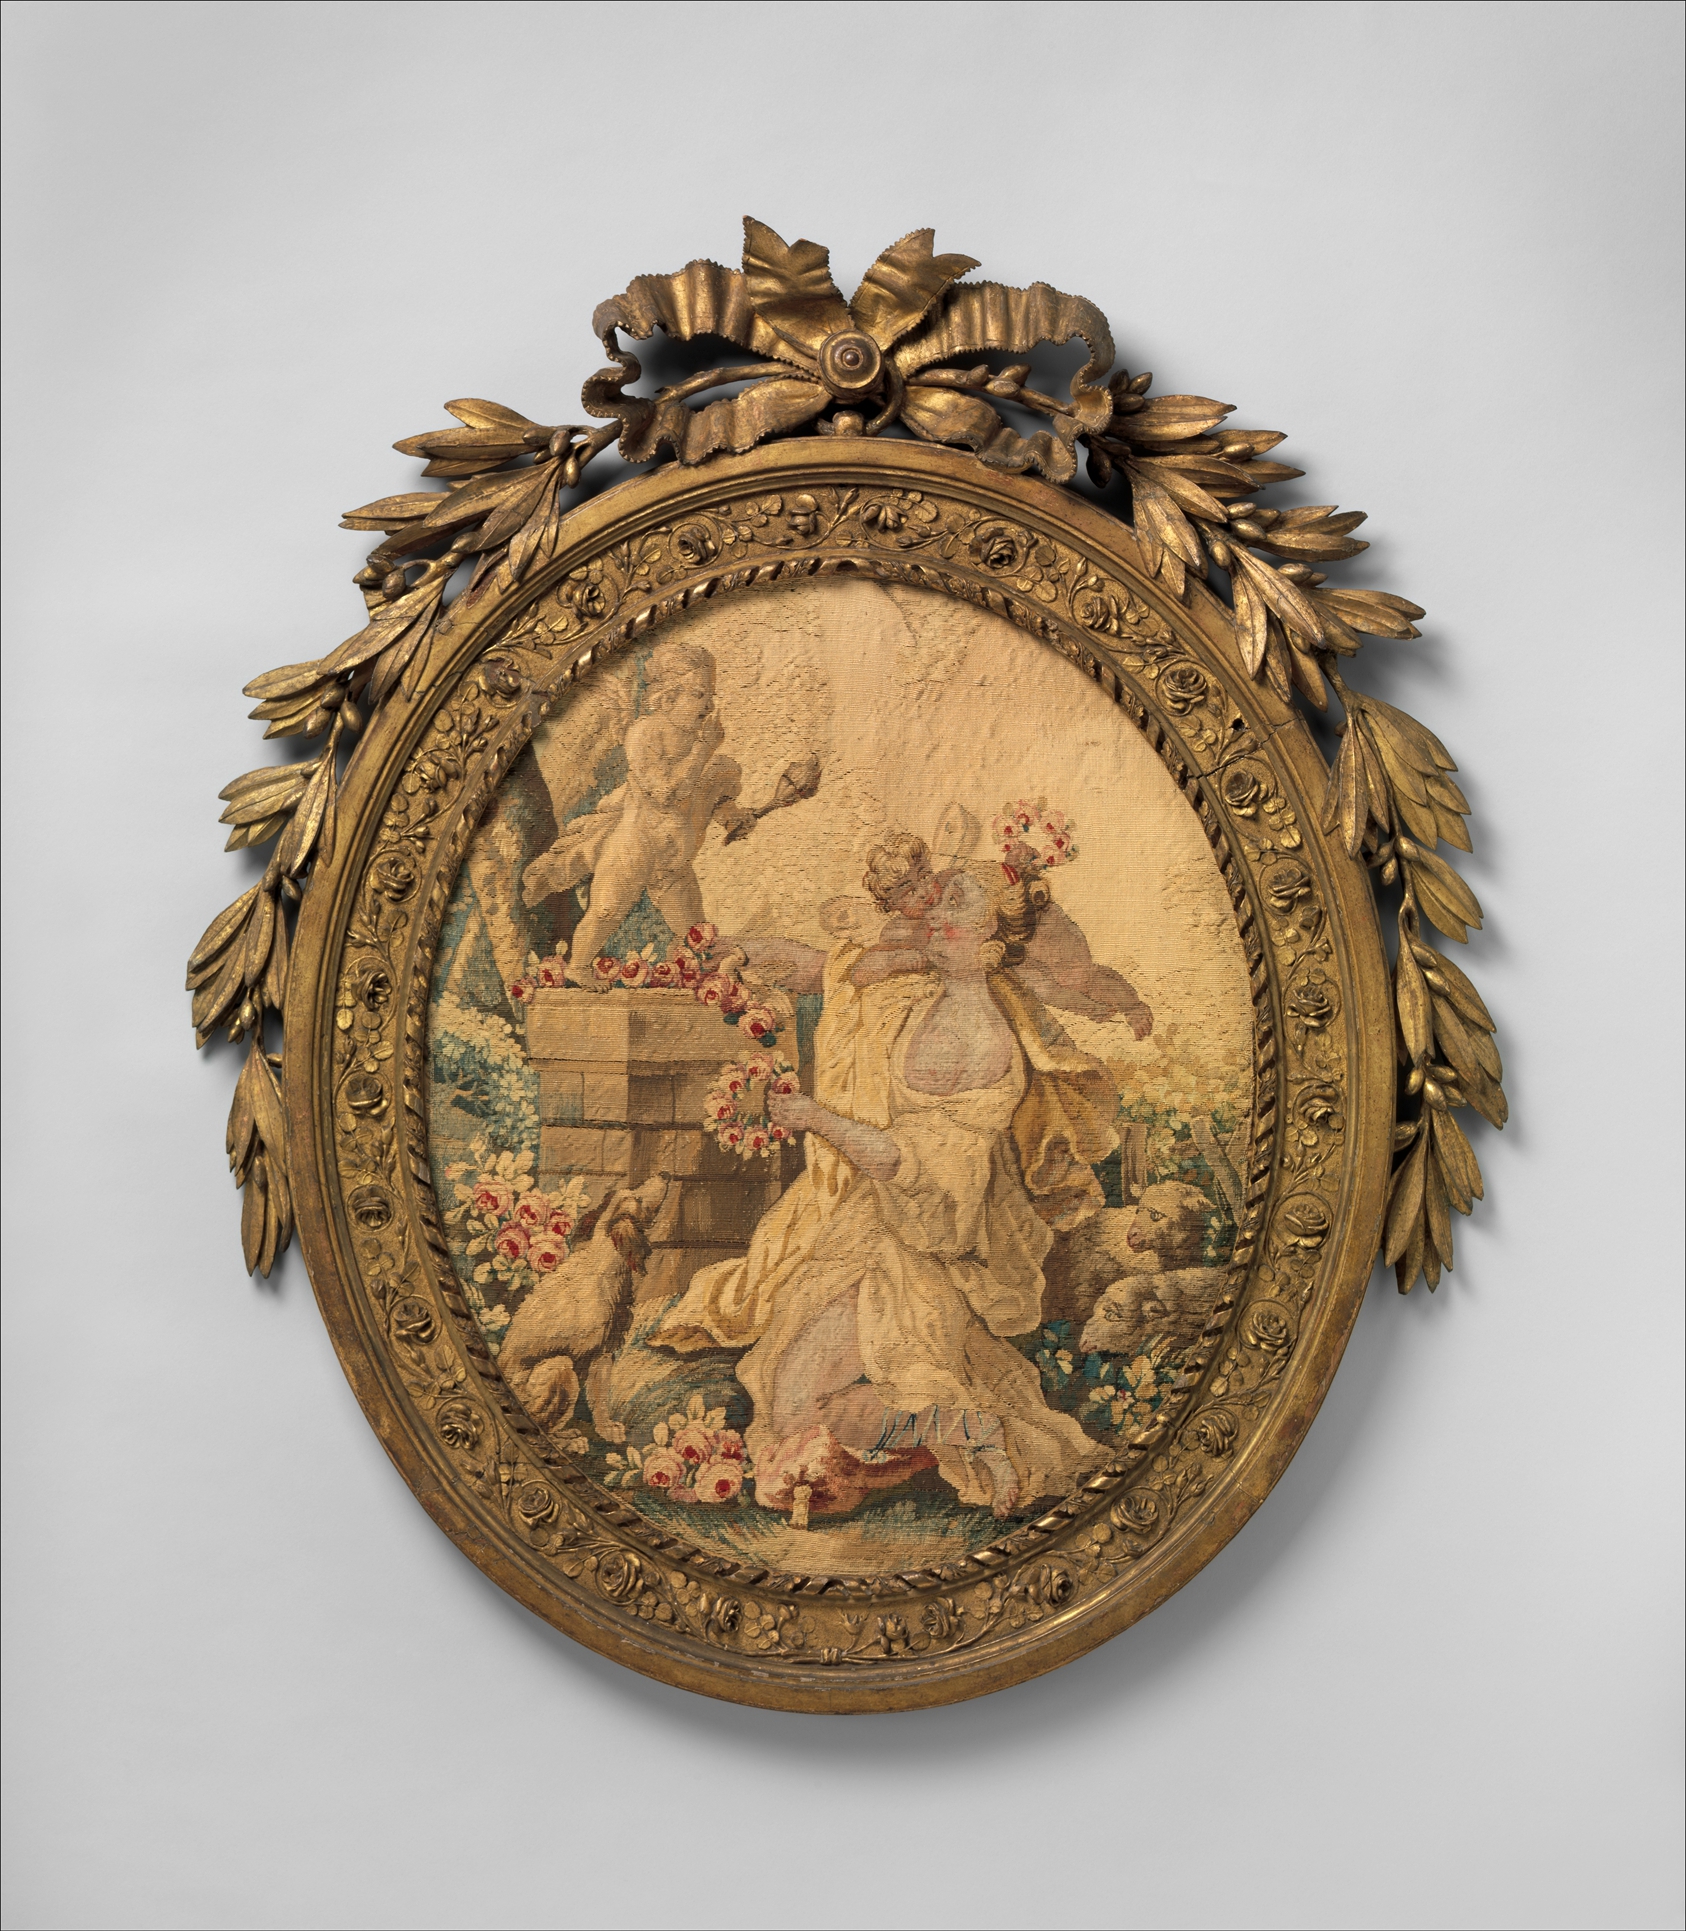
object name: frame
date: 1701-1800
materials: wood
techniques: carving, gilding